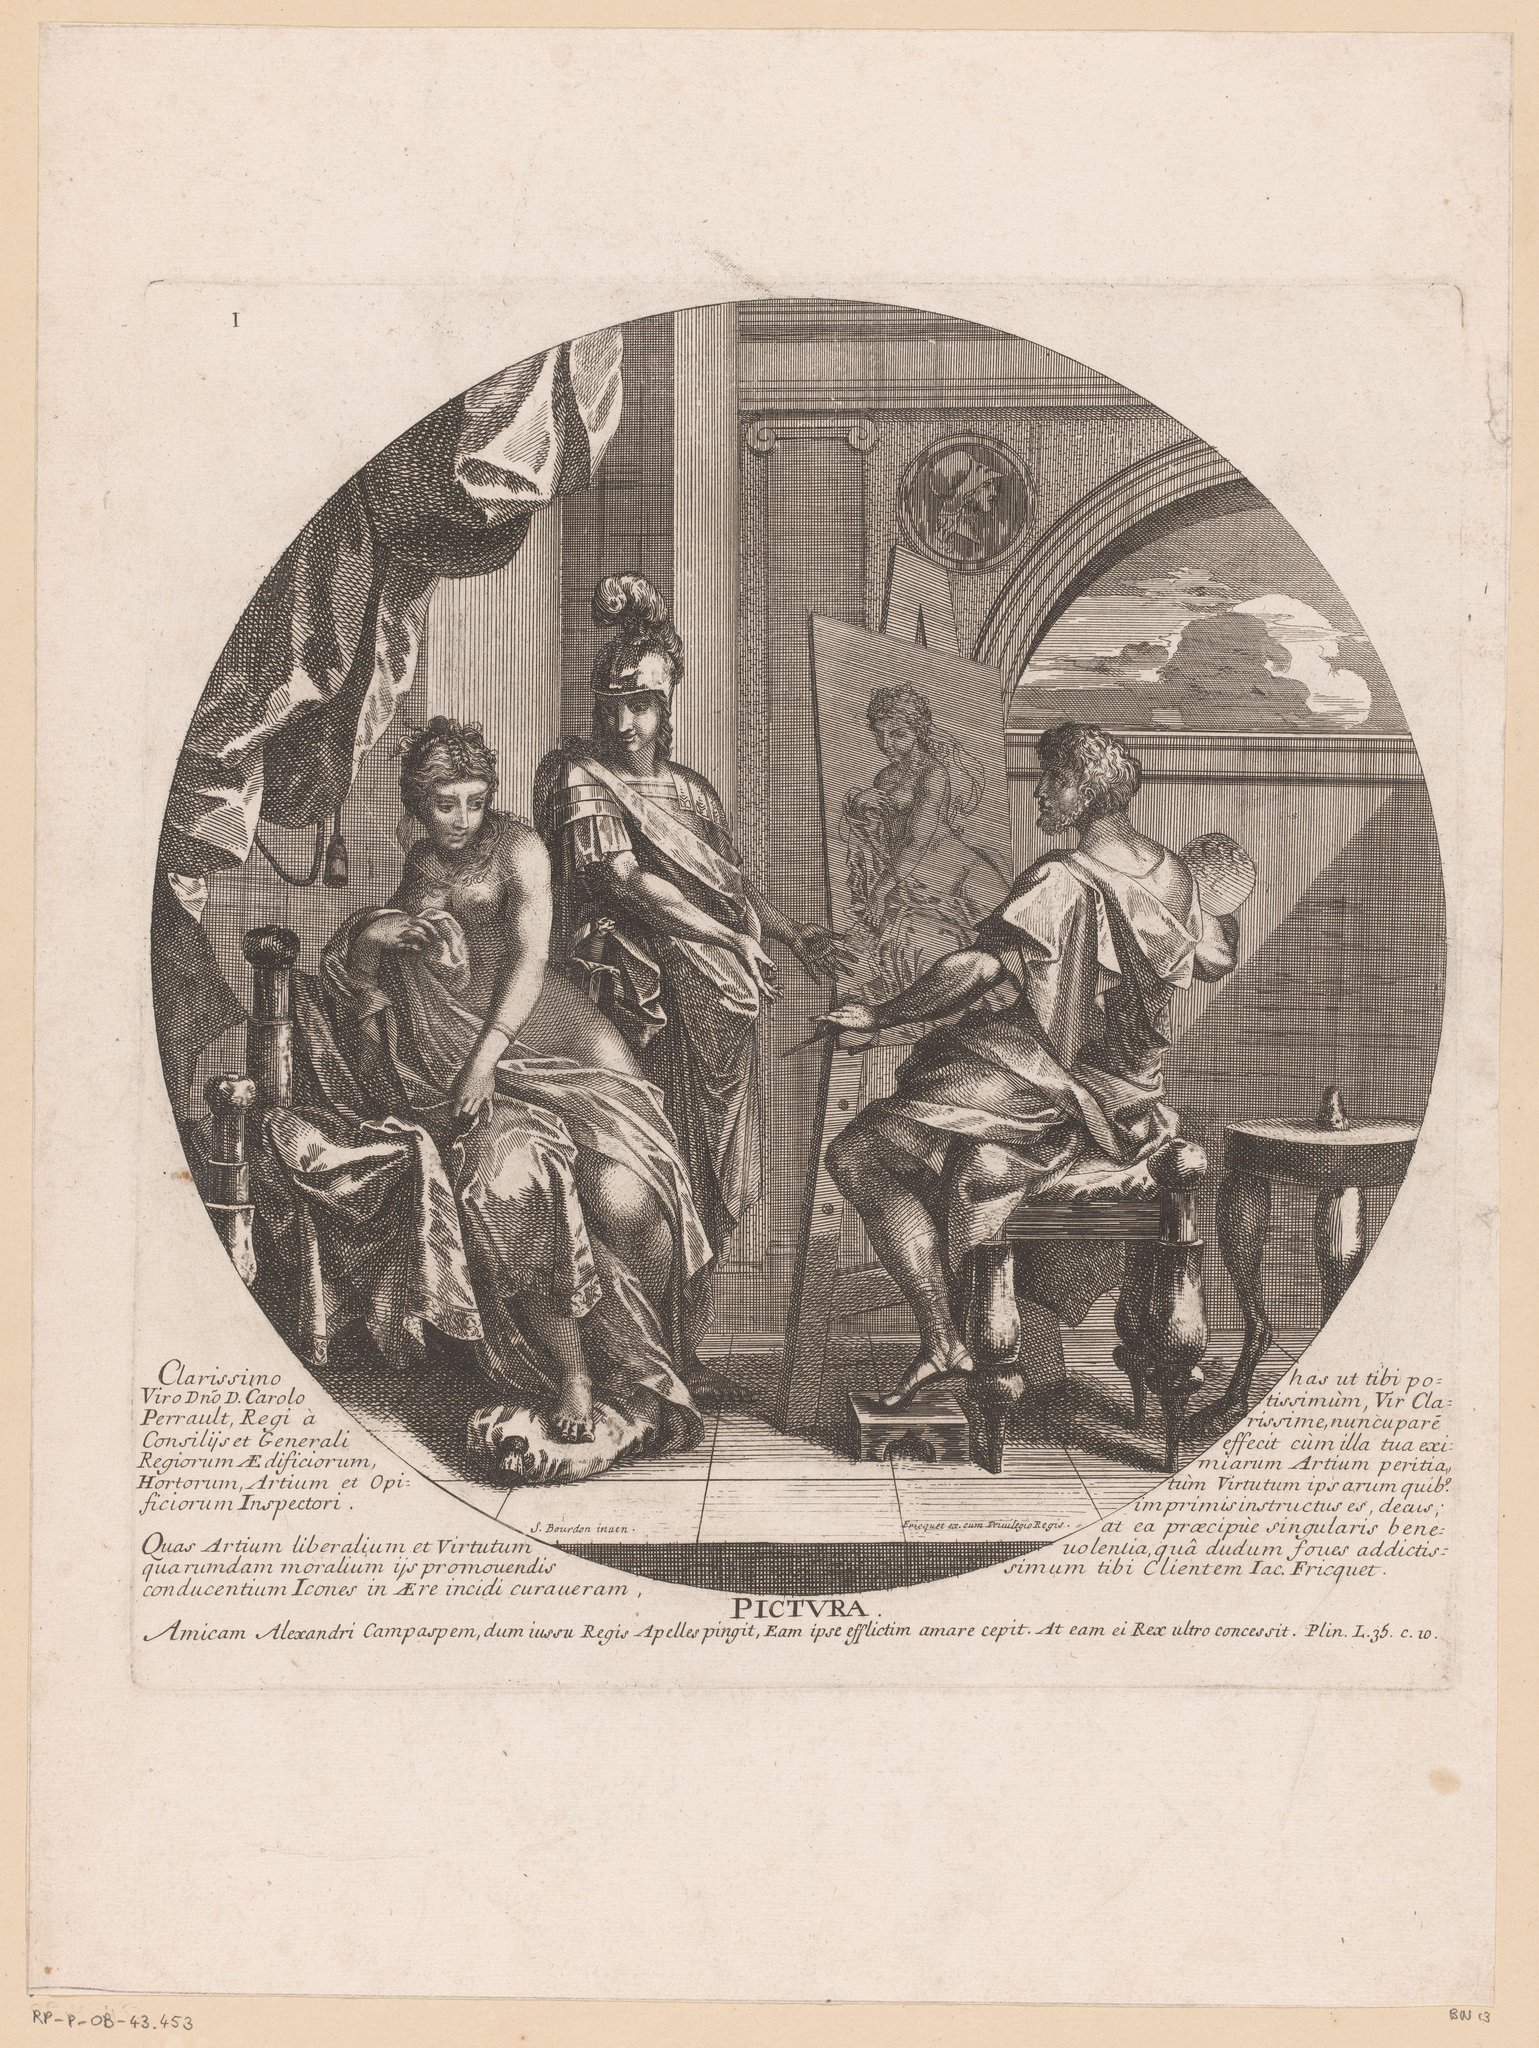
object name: print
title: Vrije kunsten en deugden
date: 1663-1716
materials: paper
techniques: engraving, etching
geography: france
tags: apelles, 'pictura', symbolic representations, allegories and emblems ~ painting; 'pittura' (ripa), historical persons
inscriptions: collector's mark: Lugt 240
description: Maakt deel uit van een veertiendelige serie opgedeeld in twee reeksen, met als onderwerp de zeven vrije kunsten en deugden naar schilderijen door Sébastien Bourdon. De schilderijen werden in 1663 vervaardigd voor de Grande Galerie van het Hôtel de Bretonvilliers te Parijs.